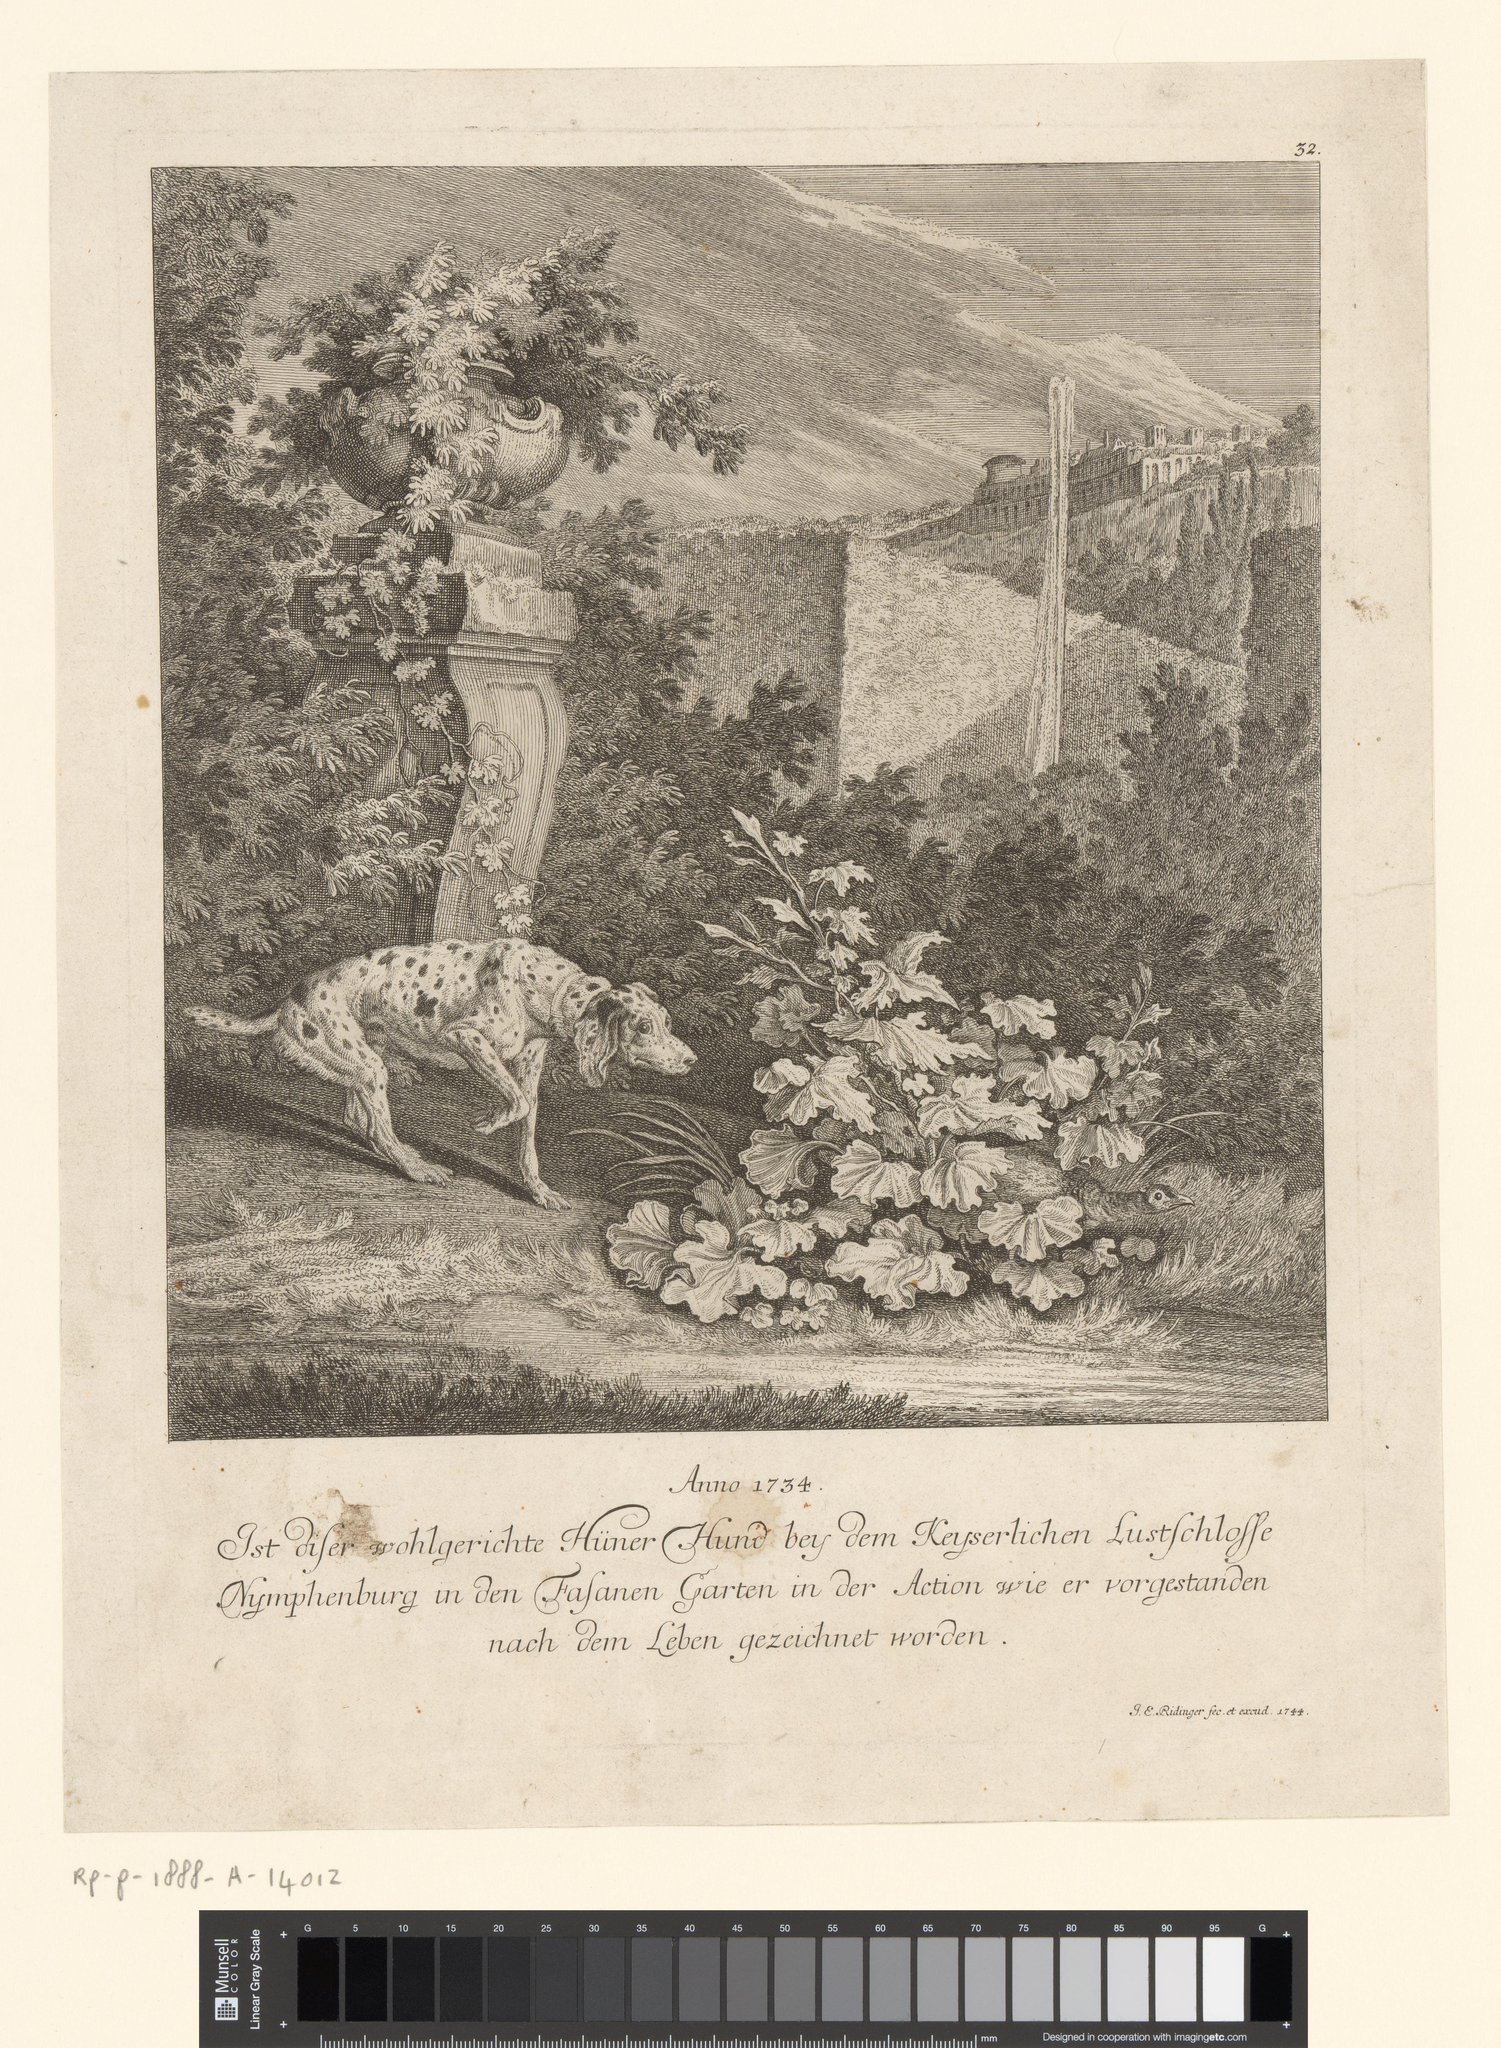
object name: print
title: Patrijshond en patrijs in Nymphenburg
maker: johann elias ridinger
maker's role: draughtsman, painter, print maker, publisher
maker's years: 1698-1767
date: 1744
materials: paper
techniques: etching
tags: hunting dogs, walker and runner birds: partridge, landscapes - hh - ideal landscapes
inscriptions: collector's mark: Lugt 2228